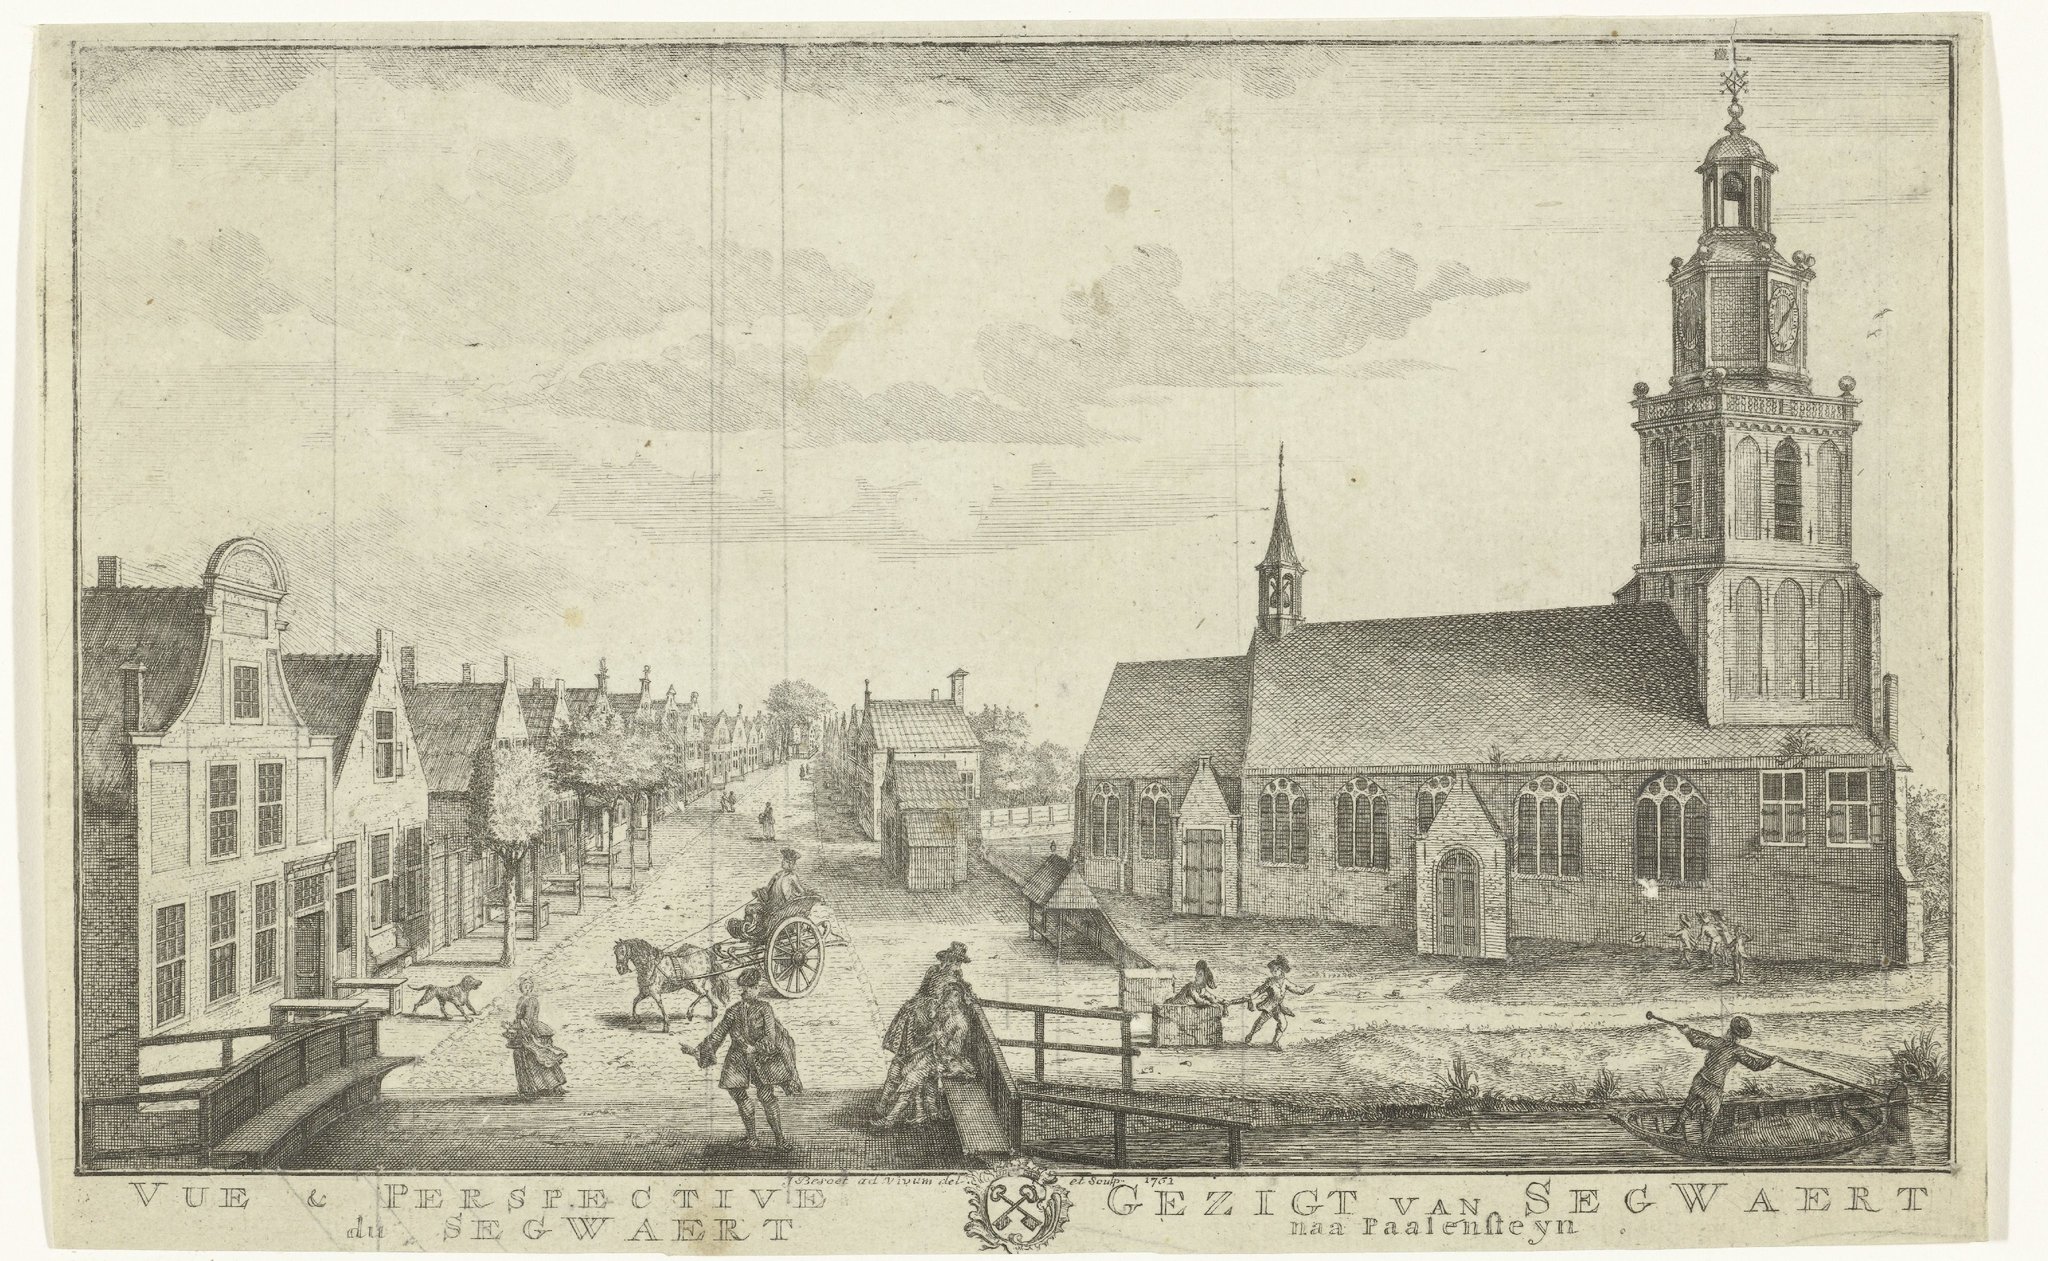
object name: print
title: Dorpsgezicht met Hervormde Kerk in Dorpsstraat te Zegwaart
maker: iven besoet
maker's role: print maker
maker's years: 1720-1769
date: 1762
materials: paper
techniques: engraving, etching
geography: netherlands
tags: zegwaart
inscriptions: date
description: Dorpsgezicht met Hervormde Kerk in Dorpsstraat te Zegwaart. Op de prent is de kerk voor de afbraak in 1784 weergegeven. De toren bleef staan. Opvallend is de aanwezigheid van een spuithuisje voor de waterpomp en brandslang van de brandweer tegen de zijgevel van de kerk bij het koor. De prent werd later doorgeprikt om de voorstelling over te nemen.